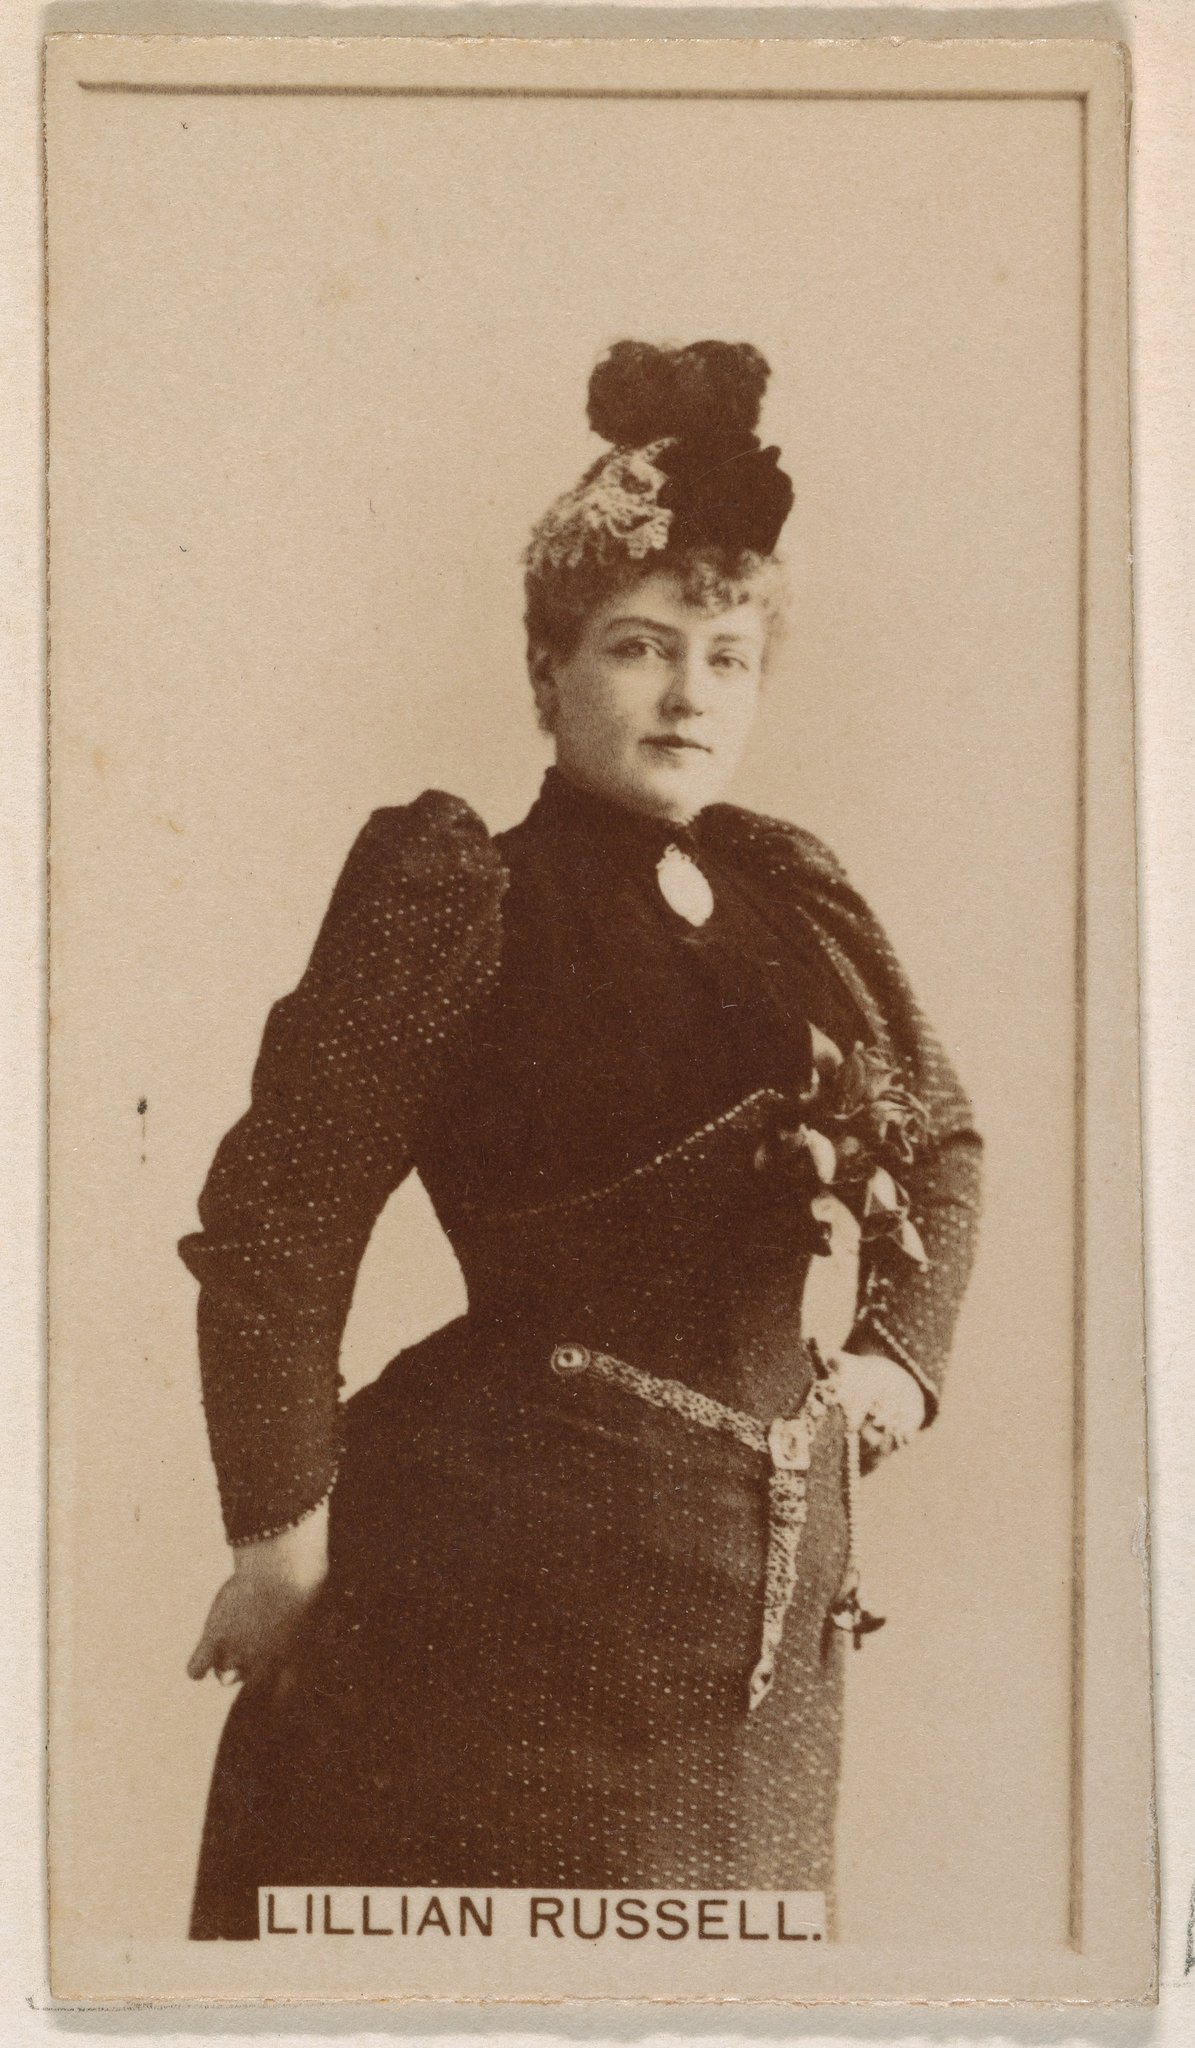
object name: photograph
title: Lillian Russell, from the Actresses series (N245) issued by Kinney Brothers to promote Sweet Caporal Cigarettes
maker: kinney brothers tobacco company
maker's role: publisher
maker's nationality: american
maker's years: 1869-2011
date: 1890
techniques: albumen silver print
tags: portraits,women,actresses